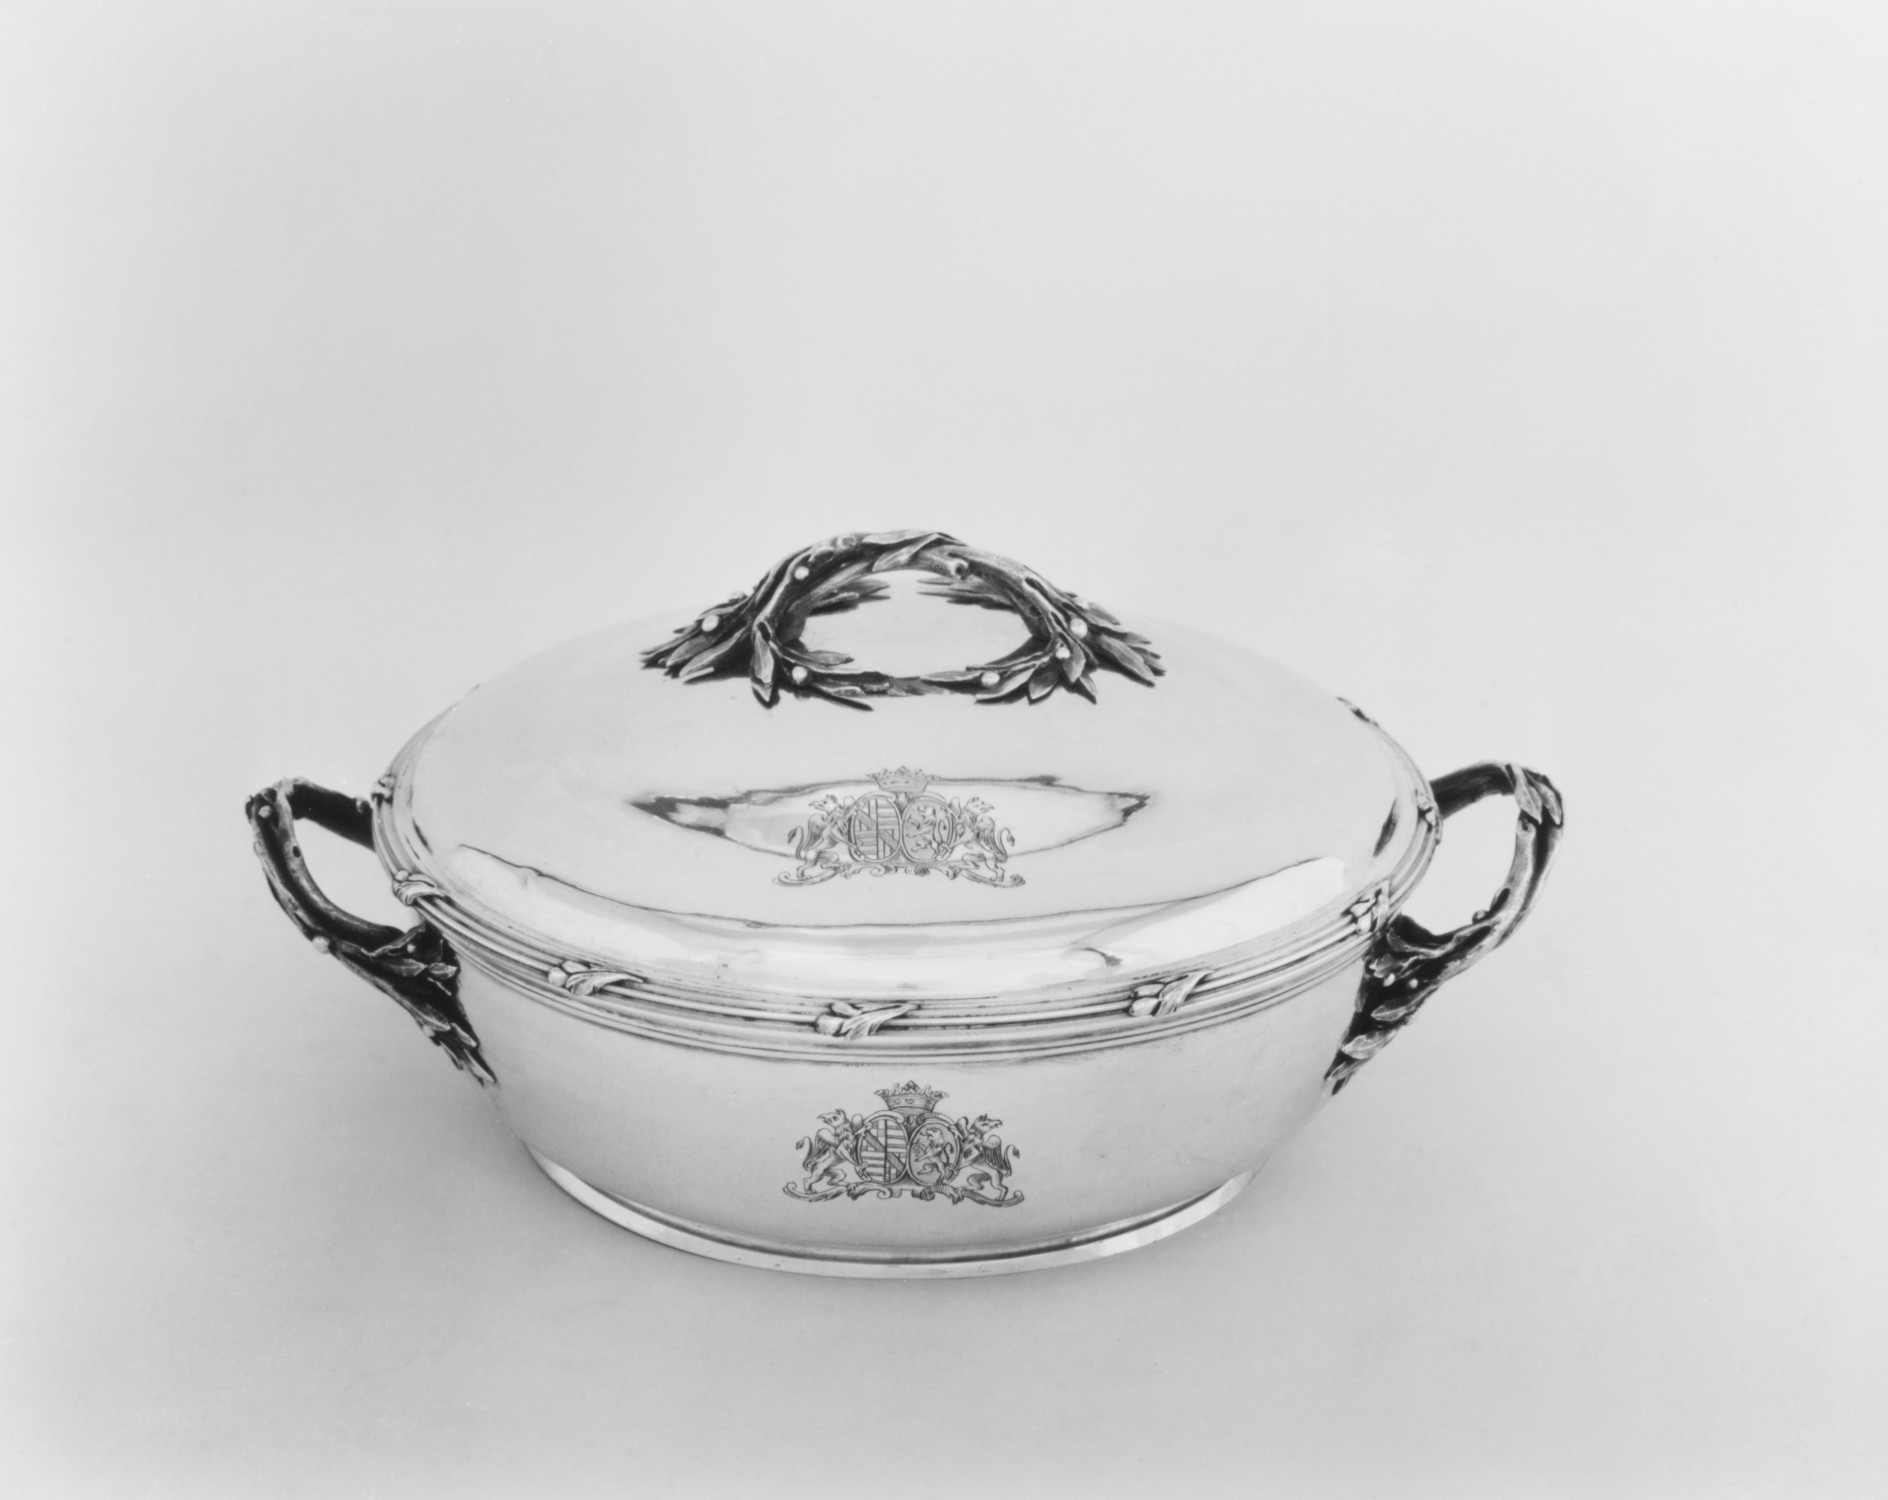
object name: dish with cover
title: Dish with cover (one of a pair)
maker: charles-louis-auguste spriman (or spriment)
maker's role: maker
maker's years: 1745-1825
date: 1778-1779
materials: silver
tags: coat of arms